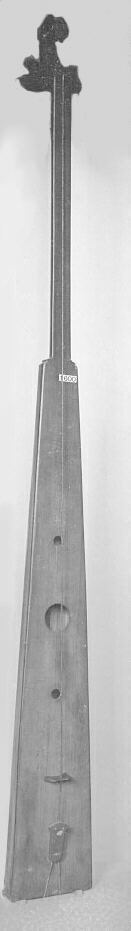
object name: tromba marina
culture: german or swiss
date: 1701-1800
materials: wood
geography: germany